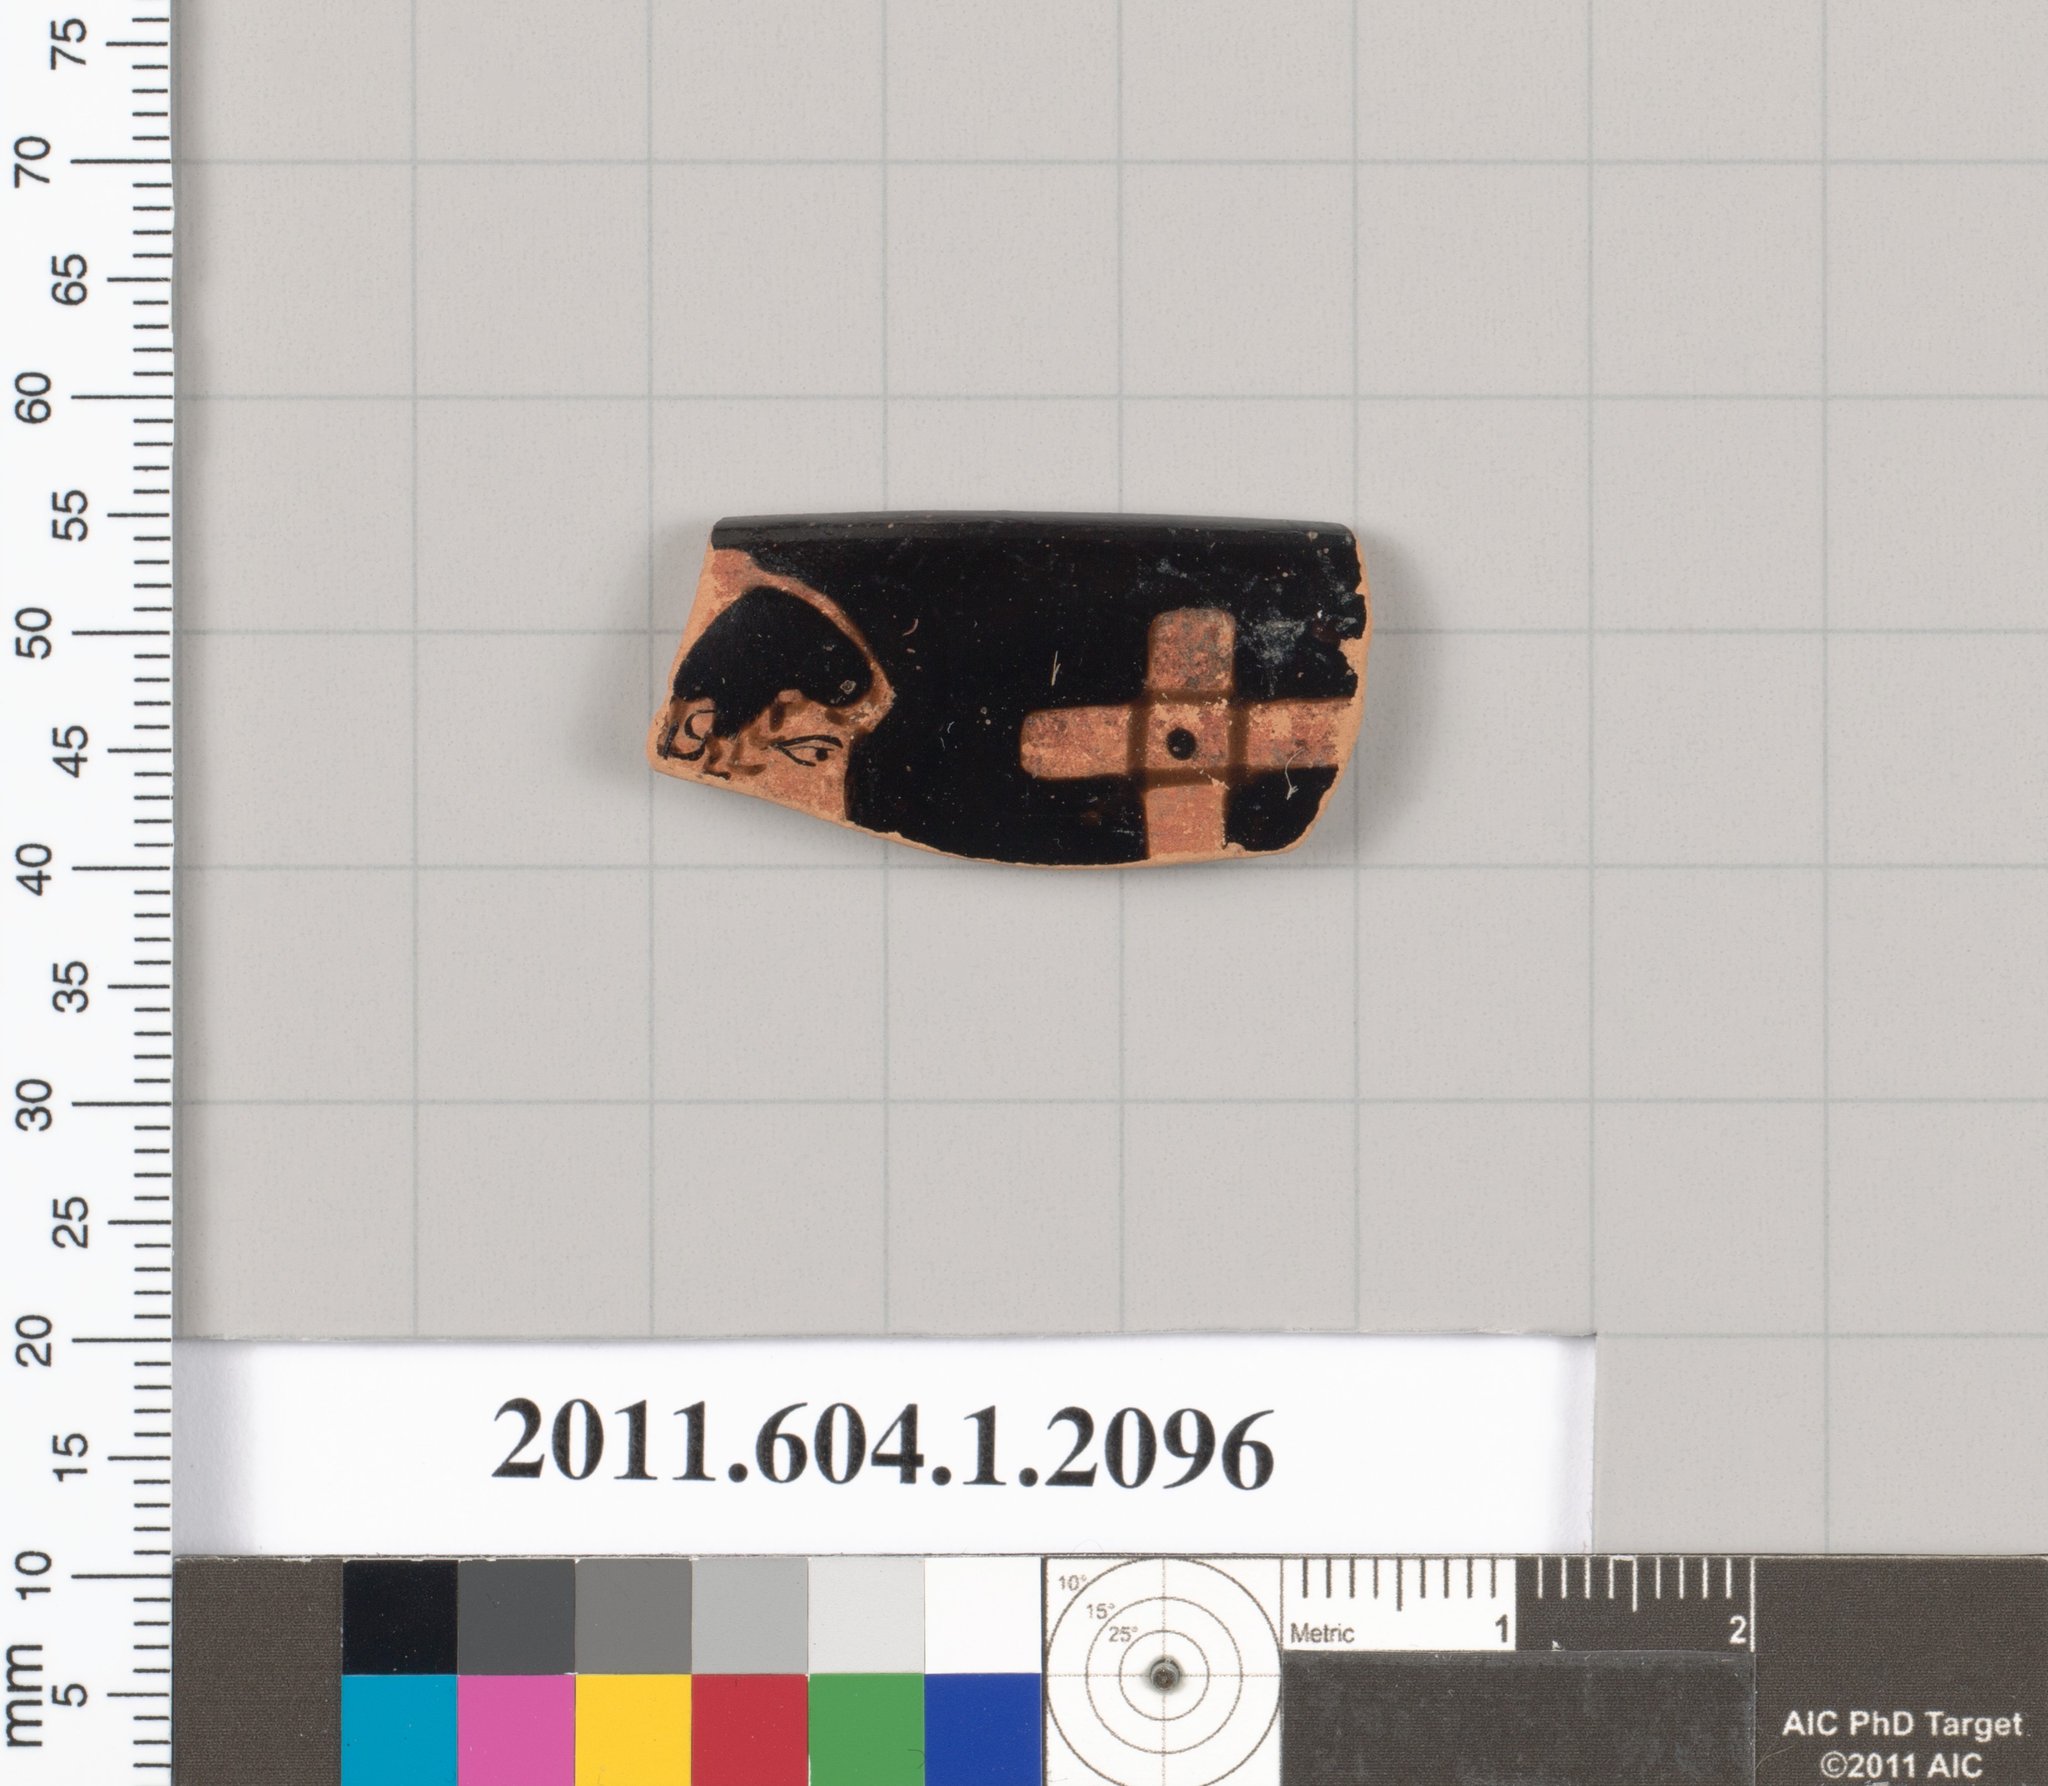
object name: kylix fragment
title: Terracotta rim fragment of a kylix (drinking cup)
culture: greek, attic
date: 460-450 BCE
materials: terracotta